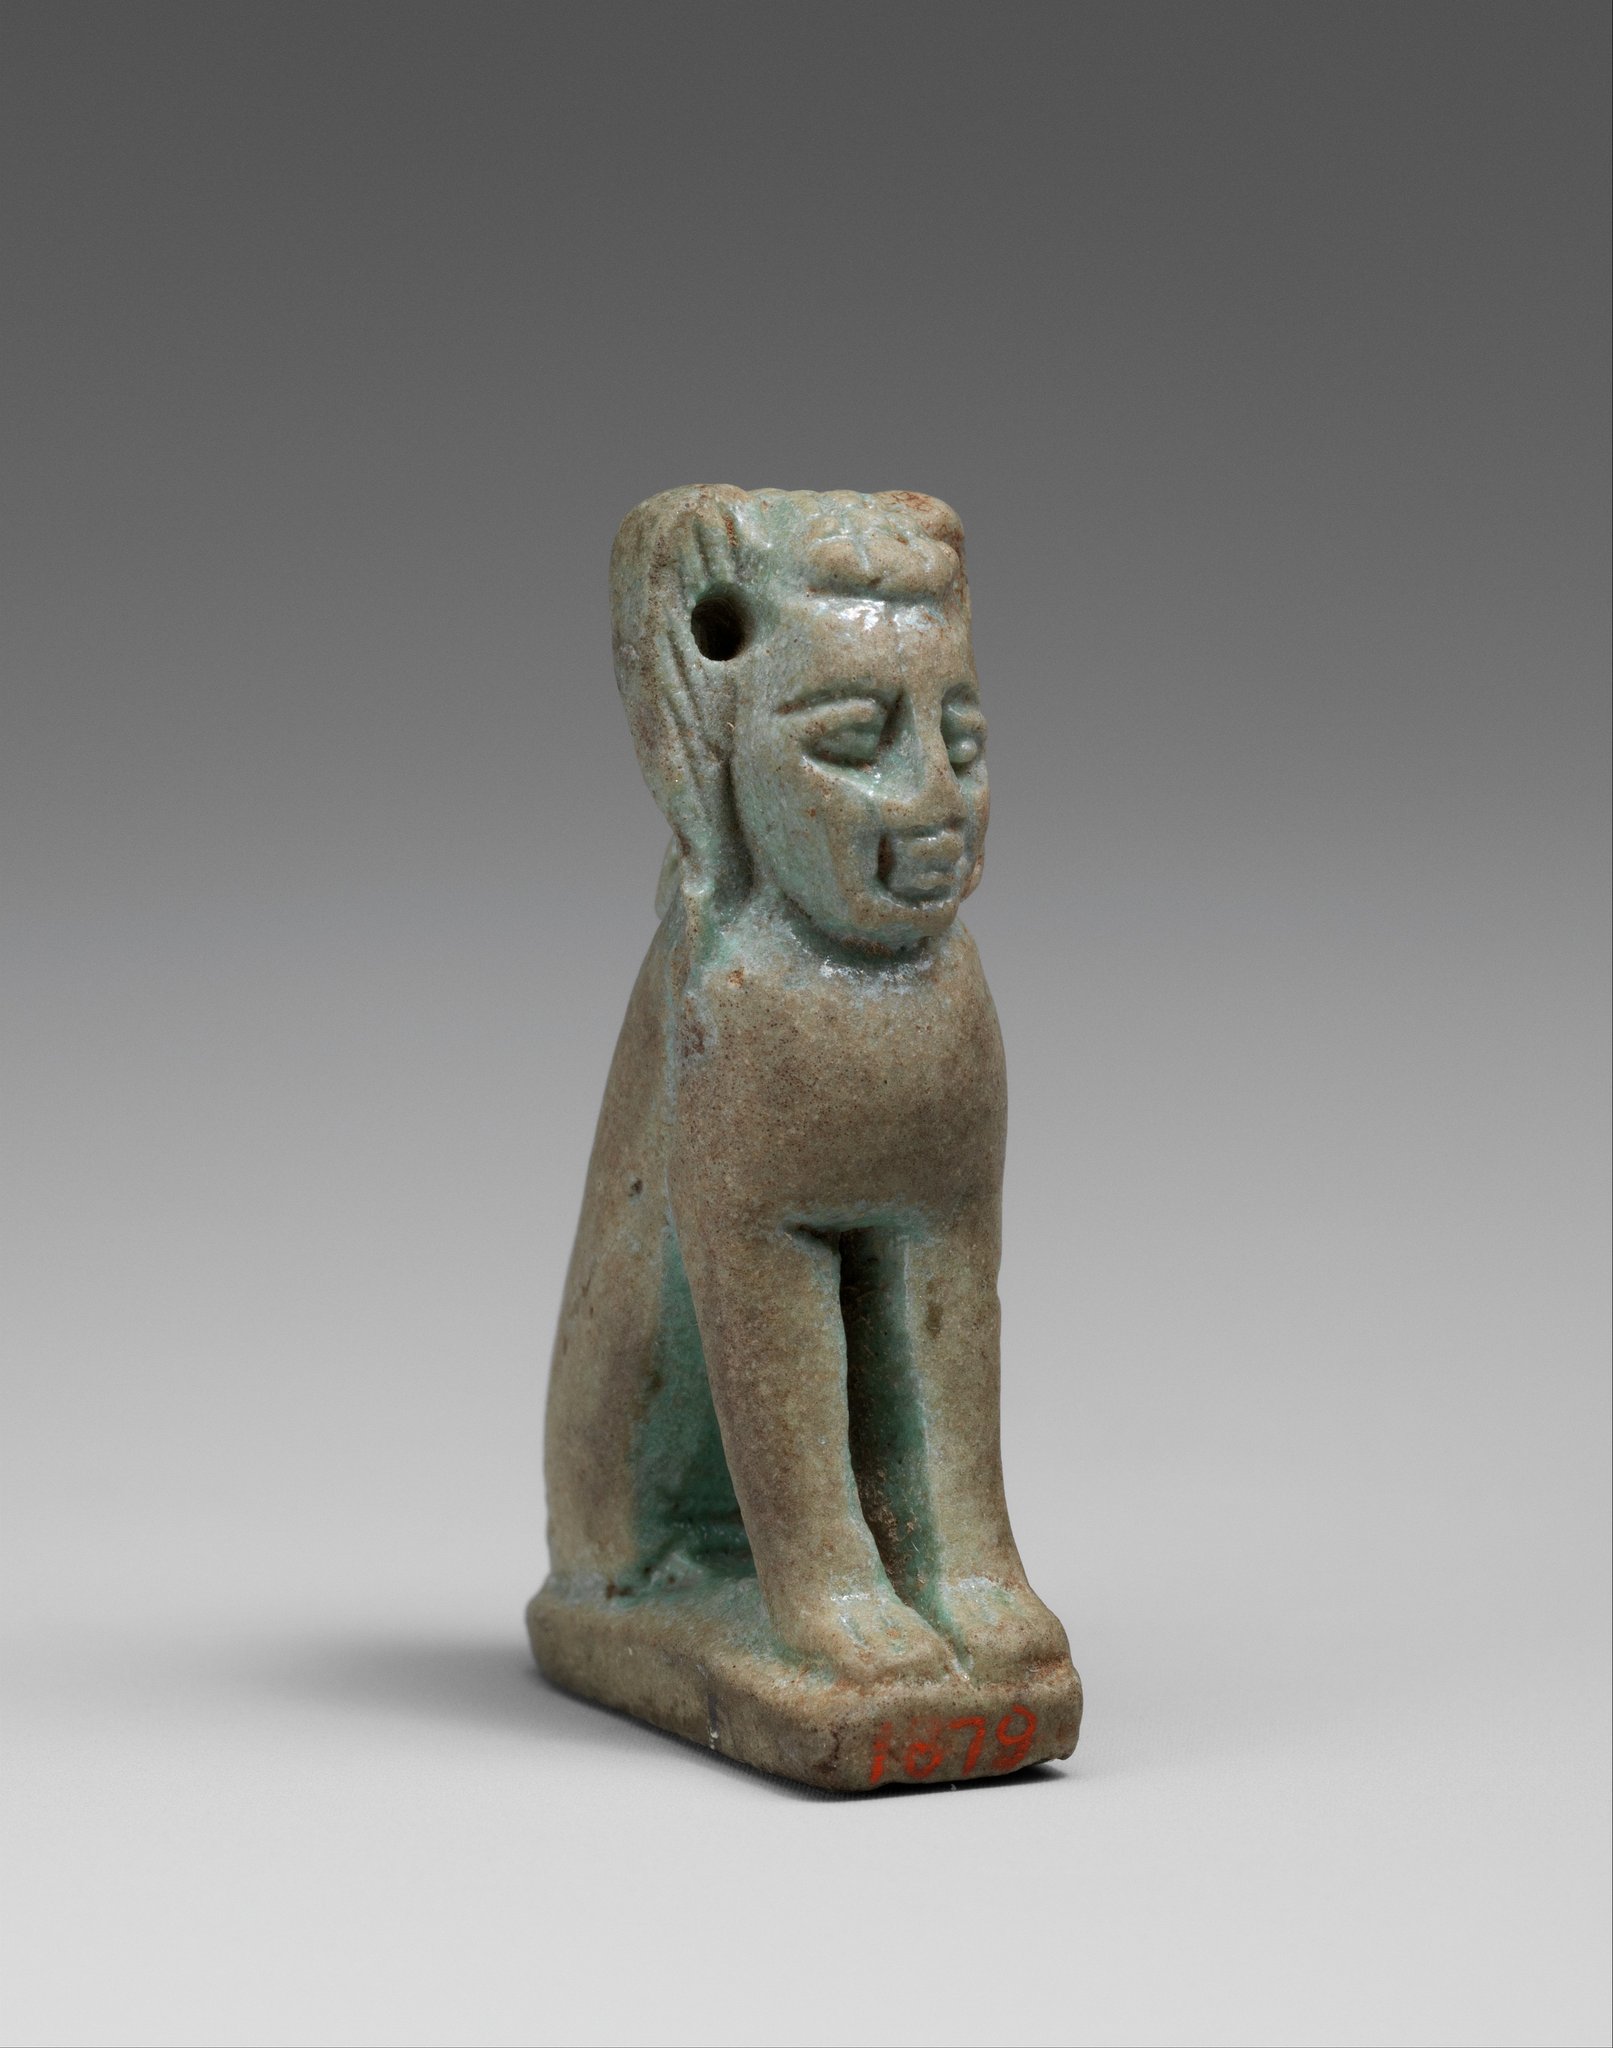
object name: amulet, human headed cat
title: Human-headed cat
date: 945-525 BCE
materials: faience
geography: egypt